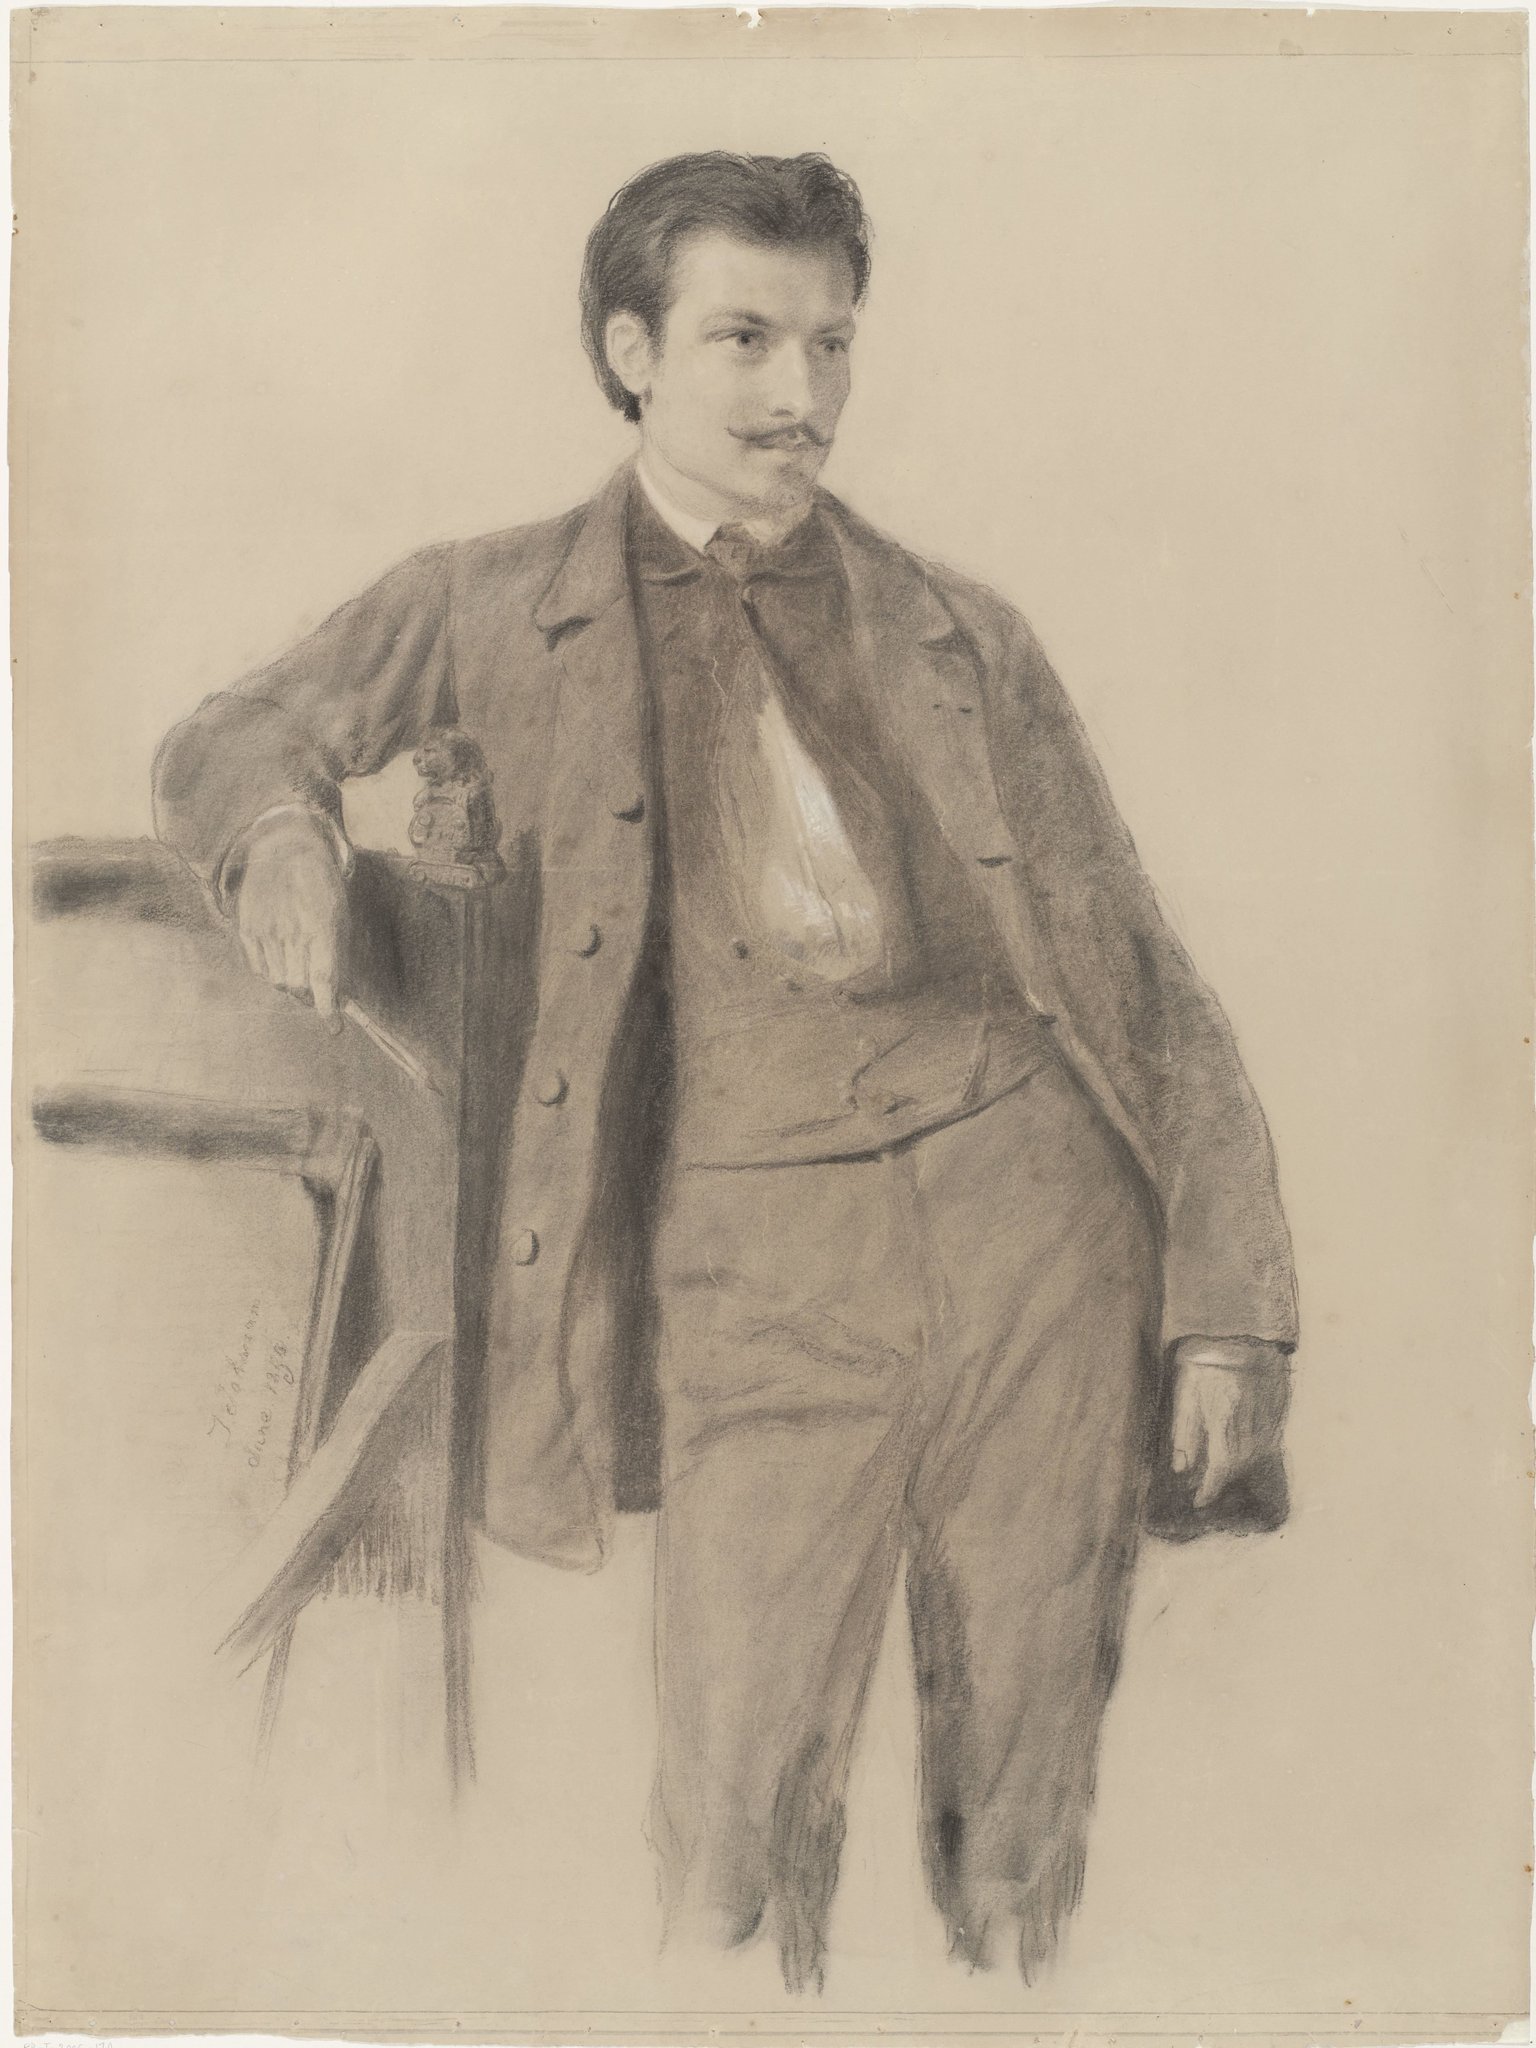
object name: drawing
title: Portret van Johan Daniël Koelman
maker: eastman johnson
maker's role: draughtsman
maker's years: 1824-1906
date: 1806-1850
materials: chalk, paper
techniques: stumping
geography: the hague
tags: the hague, print maker, draughtsman, johan daniël koelman, historical persons, portrait, self-portrait of painter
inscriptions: signature and date: ‘J. Johnson / June 1850’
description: Portret van de kunstschilder Johan Daniël Koelman (1831-1857).